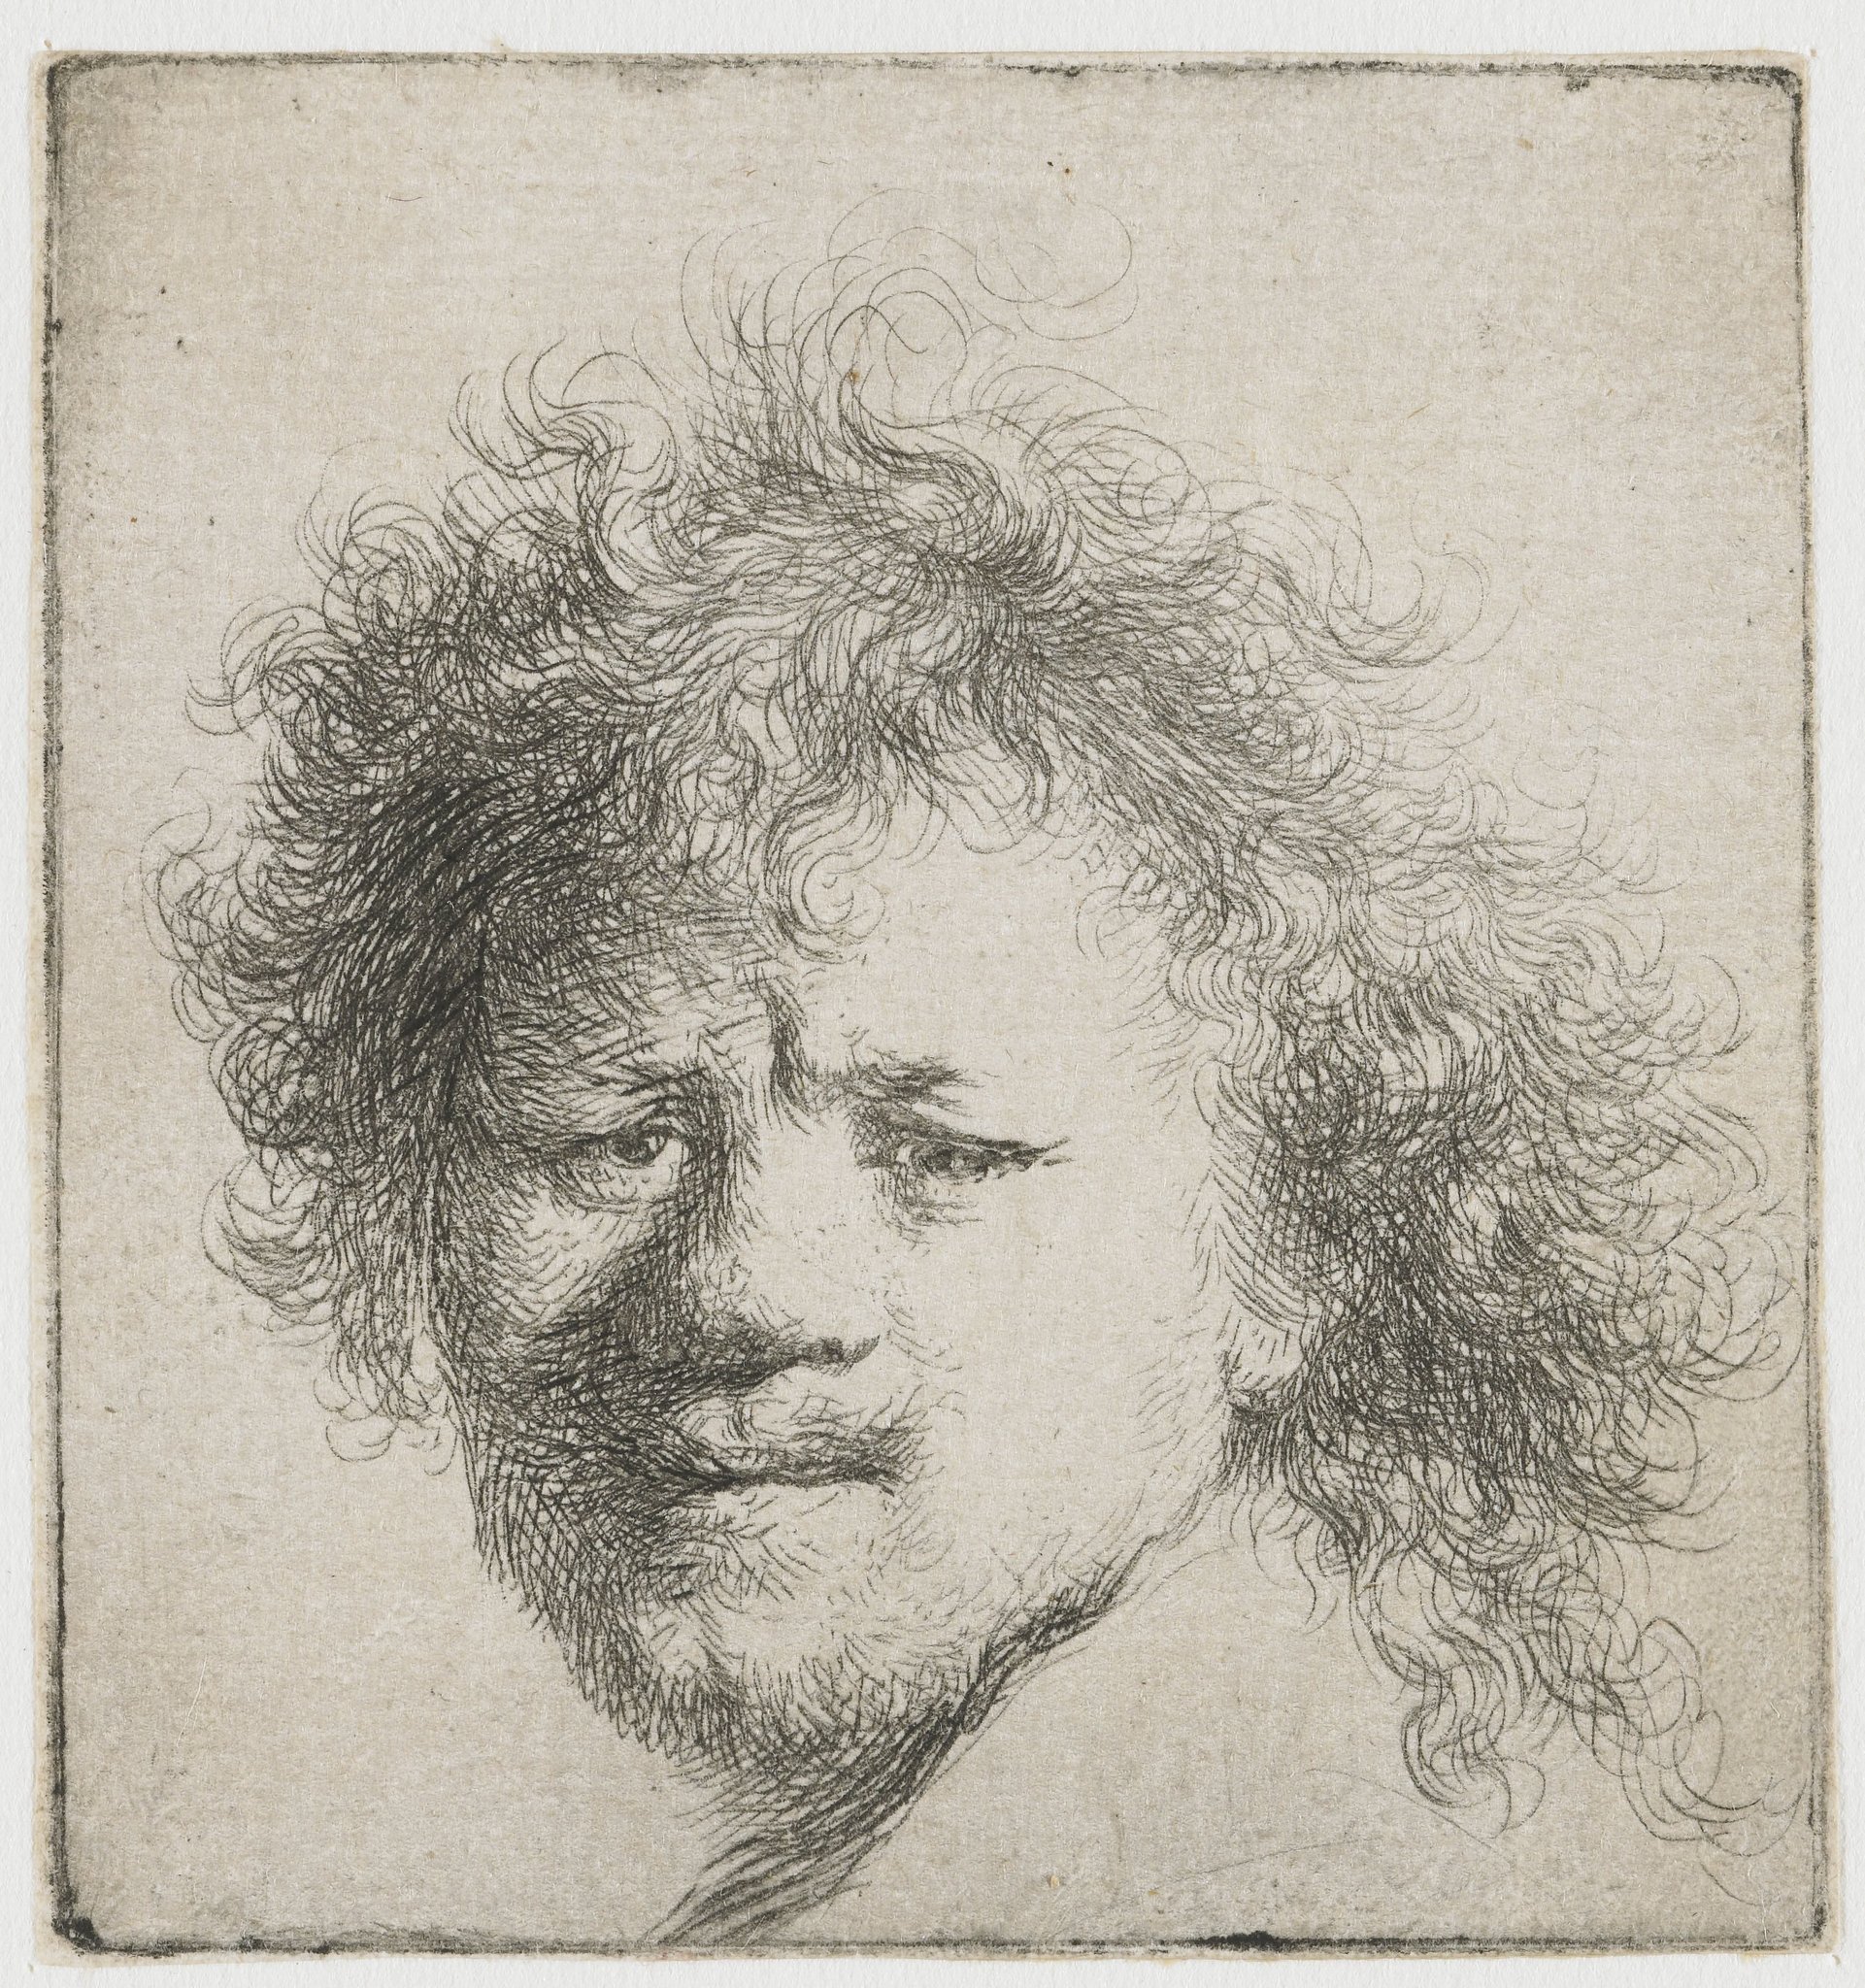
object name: print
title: Self-portrait with long bushy hair: head only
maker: rembrandt van rijn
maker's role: draughtsman, painter, print maker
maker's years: 1606-1669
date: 1631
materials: paper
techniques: etching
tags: leiden, amsterdam, painter, print maker, draughtsman, rembrandt van rijn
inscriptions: collector's mark: Lugt 2296, collector's mark: Lugt 2228